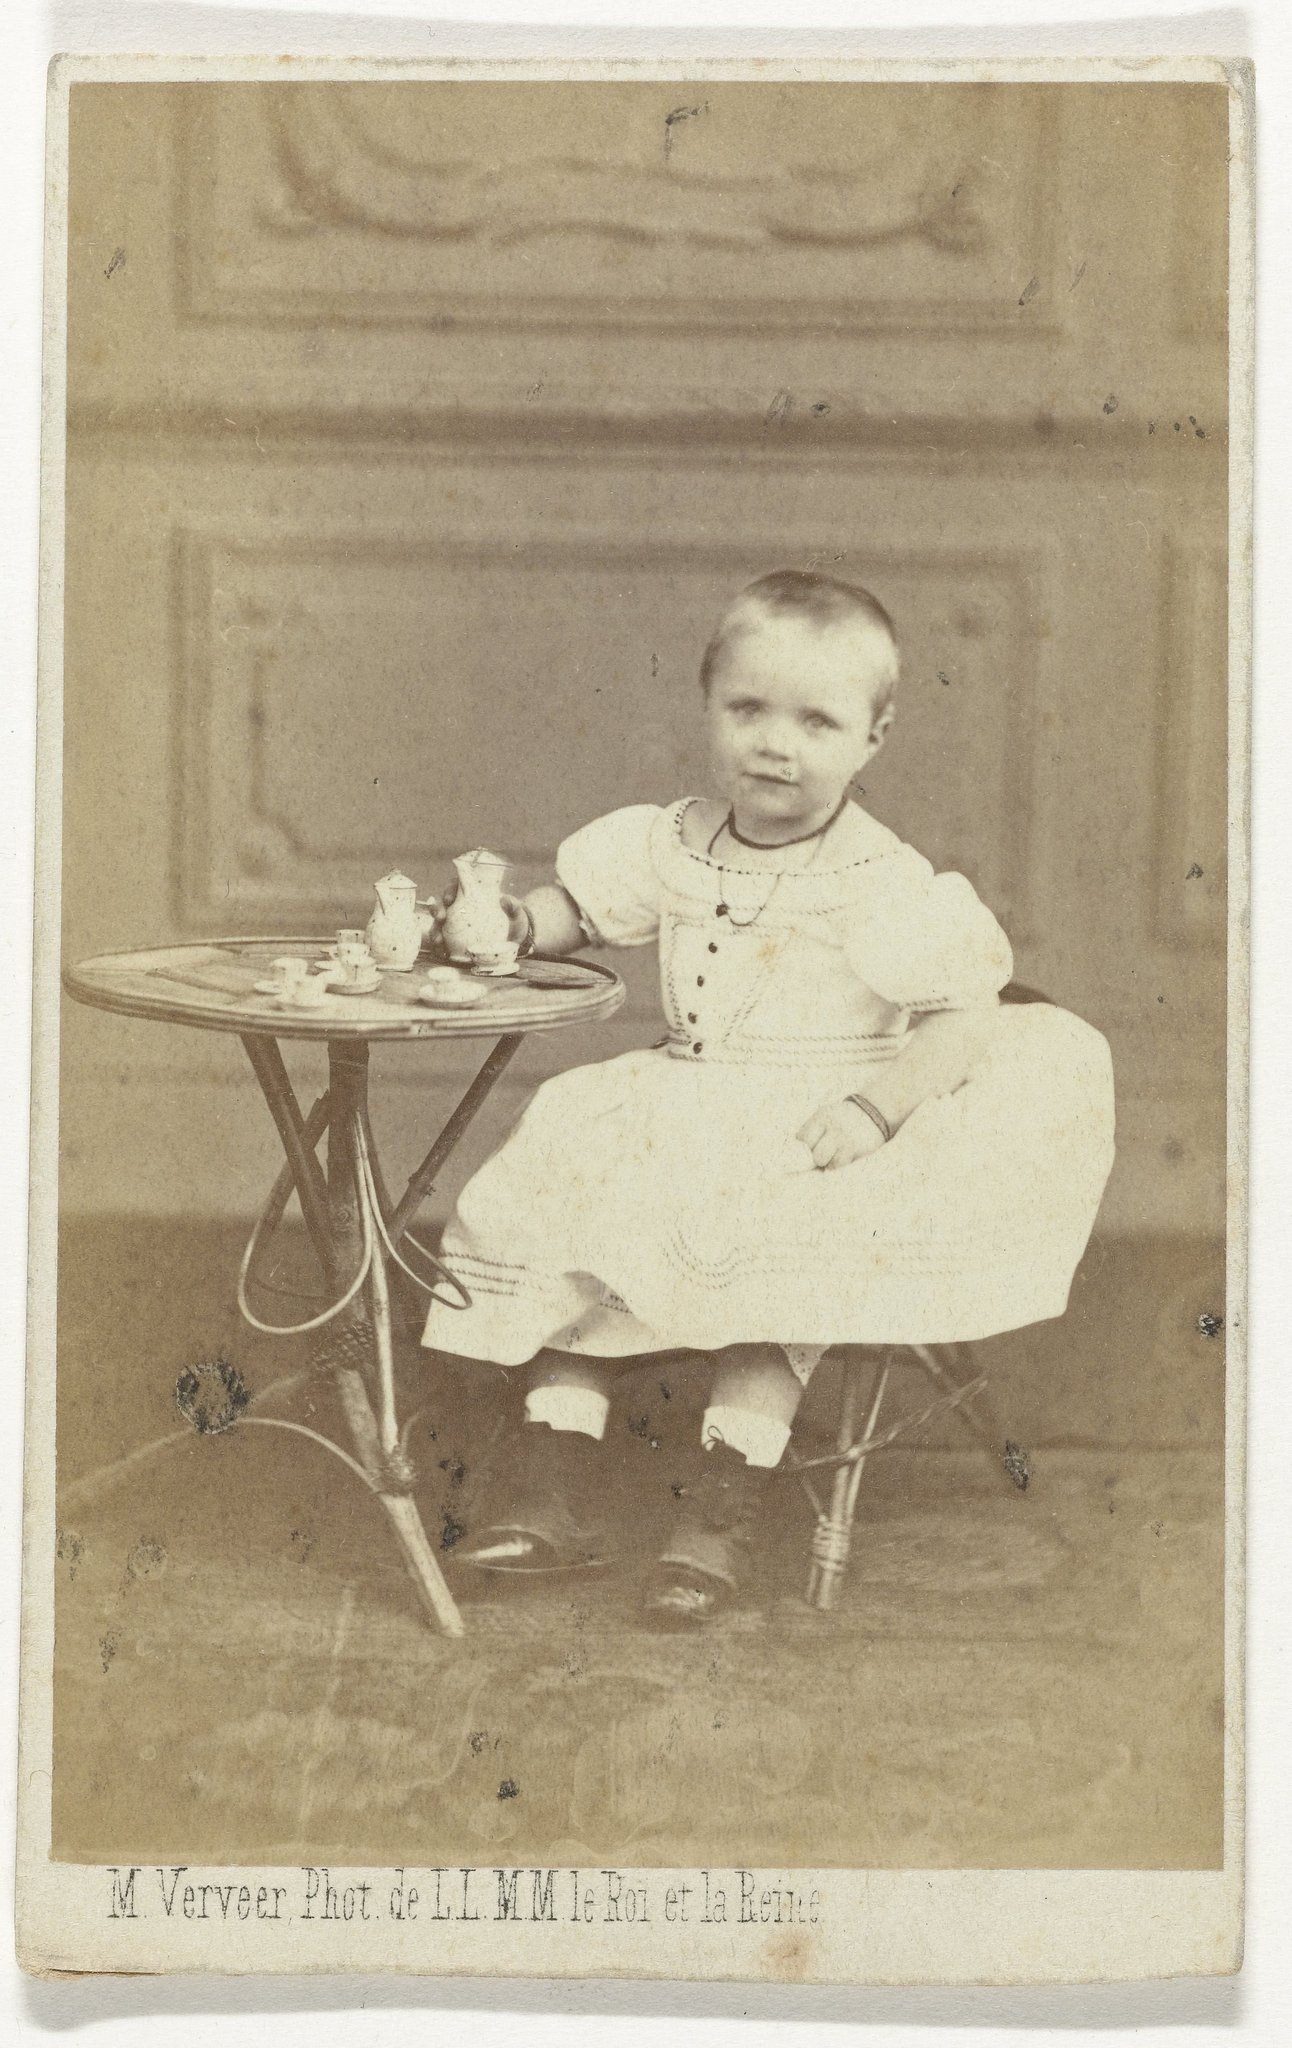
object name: photograph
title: Portret van een meisje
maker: maurits verveer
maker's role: painter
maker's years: 1817-1903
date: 1867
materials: cardboard, paper, photographic support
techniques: albumen print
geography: the hague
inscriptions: annotation: ‘Jacqueline/Augustus 1867/J. 2½ jaar oud’, coat of arms, address: ‘M. Verveer/photographe/de LLMM le Roi et la Reine des Pays-Bas/52. Zeestraat 52./vis a vis du Willemspark/La Haye’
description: Klein meisje met heel kort haar, zittend aan een tafeltje met een poppenserviesje.